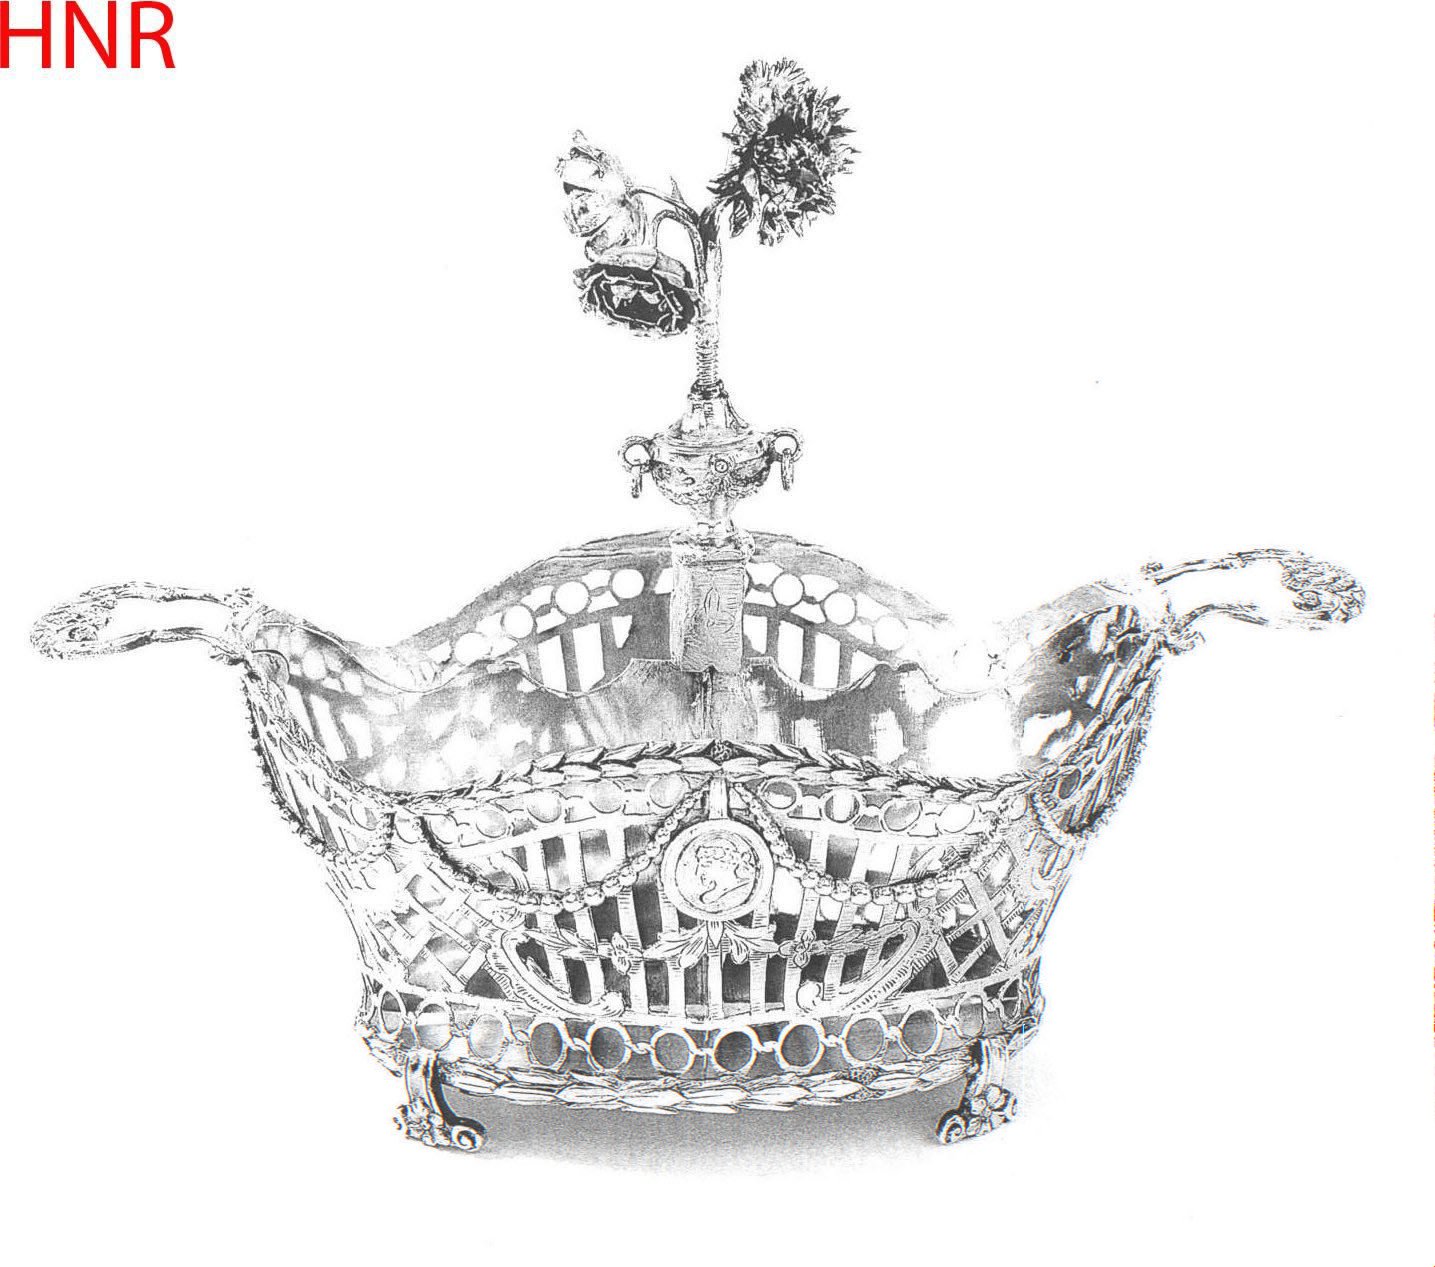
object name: basket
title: Mand met uitneembare binnenbak, ovaal, met opengewerkte wand met parelslingers en medaillons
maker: johannes horstman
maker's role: silversmith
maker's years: 1721-1804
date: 1782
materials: silver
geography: amsterdam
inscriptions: : ‘L’, date letter: ‘X’, alloy mark, maker's mark, : ‘gekroonde O’, town mark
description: De ovale mand rust op vier gegoten pootjes in de vorm van met een bloem versierde dubbele voluten. De vlakke bodem is gevat in de onderrand, die evenals de bovenrand is opgebouwd uit laurierbladeren en bessen. Langs de bovenrand zijn deze zo geplaatst, dat de bessen, waar de in tegenovergestelde richting lopende bladeren samenkomen, zich steeds in het midden van een zijde bevinden. Langs de onderrand is de plaatsing minder zorgvuldig. Op twee plaatsen bevinden de bessen zich juist op het aanhechtingspunt van een pootje. De gewelfde wand is geheel opengewerkt met gegraveerde motieven: een rand van guilloches, waarboven een middengedeelte met afwisselend reeksen verticale spijlen en traliewerk gescheiden door C-voluten met rocailles, en daarboven een rand van door bolletjes verbonden cirkels. Over de gedeeltes met spijlen lopen bloemslingers. Van de gegolfde bovenrand hangen parelslingers en vier ovale medaillons af, die op de wand zijn opgelegd. Aan beide lange zijden vertoont het medaillon een gelauwerde mannenkop in profiel. Aan beide korte zijden bevindt zich een leeg medaillon met een parelrand. De uit C-voluten opgebouwde oren zijn versierd met een rozet binnen een kabelrand en met laurierbladeren. In het midden van elke zijde is aan de binnenkant een gleufje aangebracht, waarin het uitneembare interieur past. Dit bestaat uit twee haaks op elkaar geplaatste schotten met geschulpte bovenzijden, op de kruising bekroond door een rechthoekig voetstuk, gegraveerd met rozetten op een gearceerde grond, waarop een vaas met een boeket bloemen, onder andere een roos en een chrysant. De vaas is versierd met afhangende laurierslingers en heeft ronde oren, waaraan ringen hangen. De onderzijde van het boeket, waar nu een lange schroefdraad te zien is, is waarschijnlijk gerestaureerd, evenals het voetstuk waarop de vaas staat.